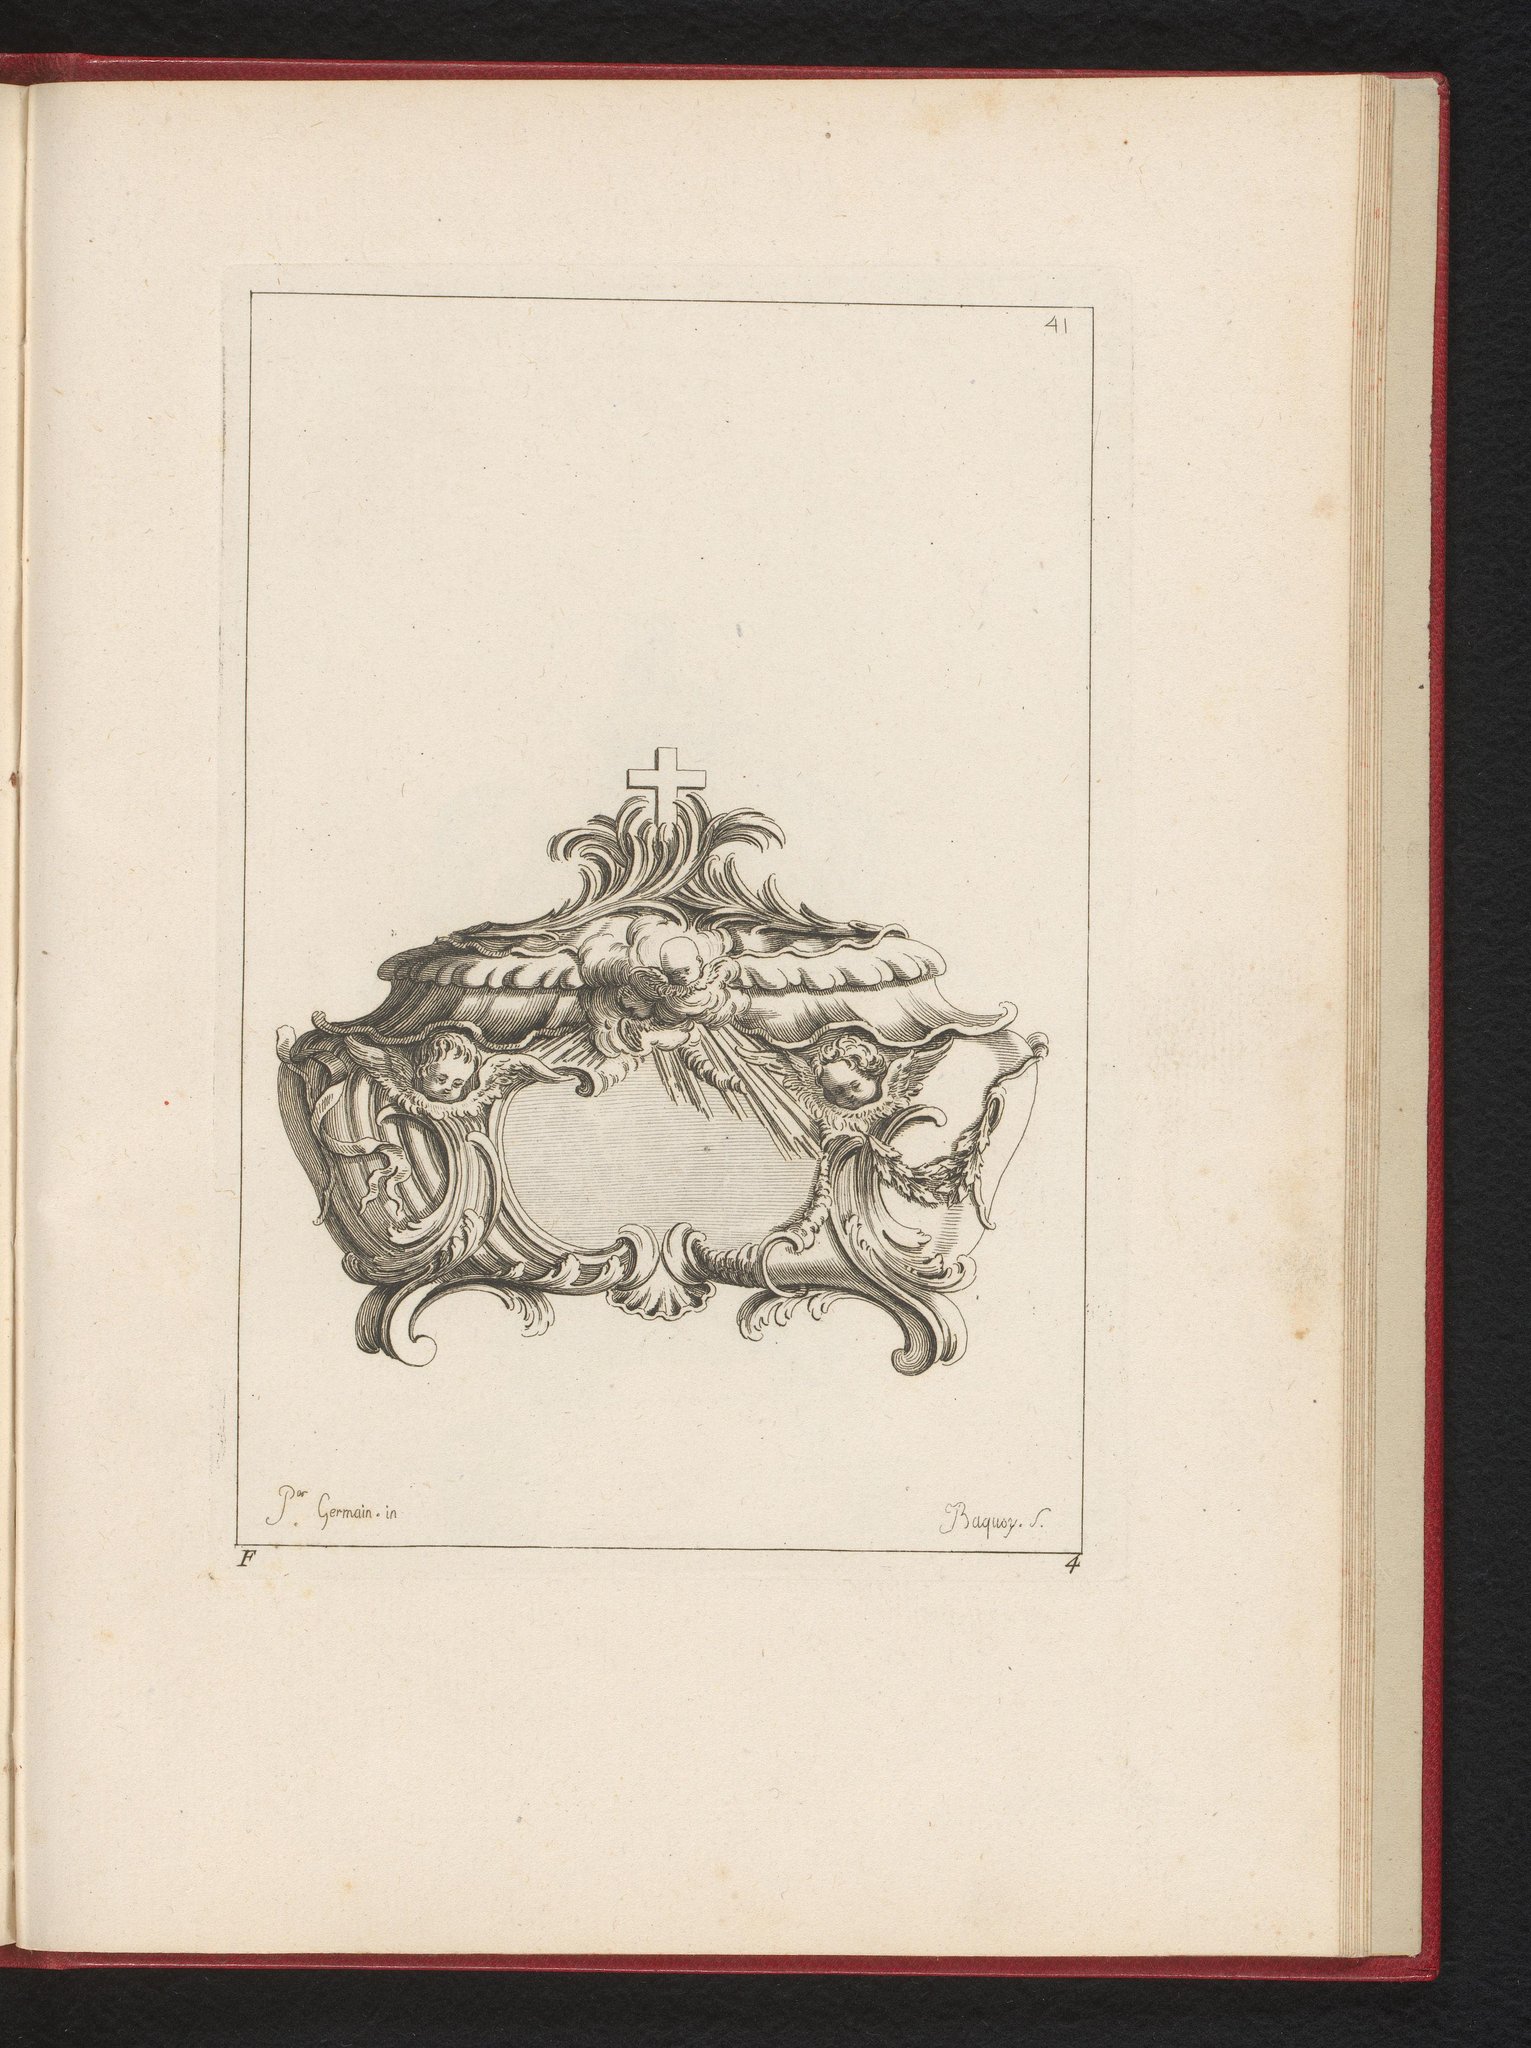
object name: print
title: Zilverwerk en edelsmeedkunst, eerste deel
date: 1748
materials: paper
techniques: etching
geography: paris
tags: relics (and reliquaries), jeweller, goldsmith, silversmith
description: Deze prent maakt deel uit van een album.